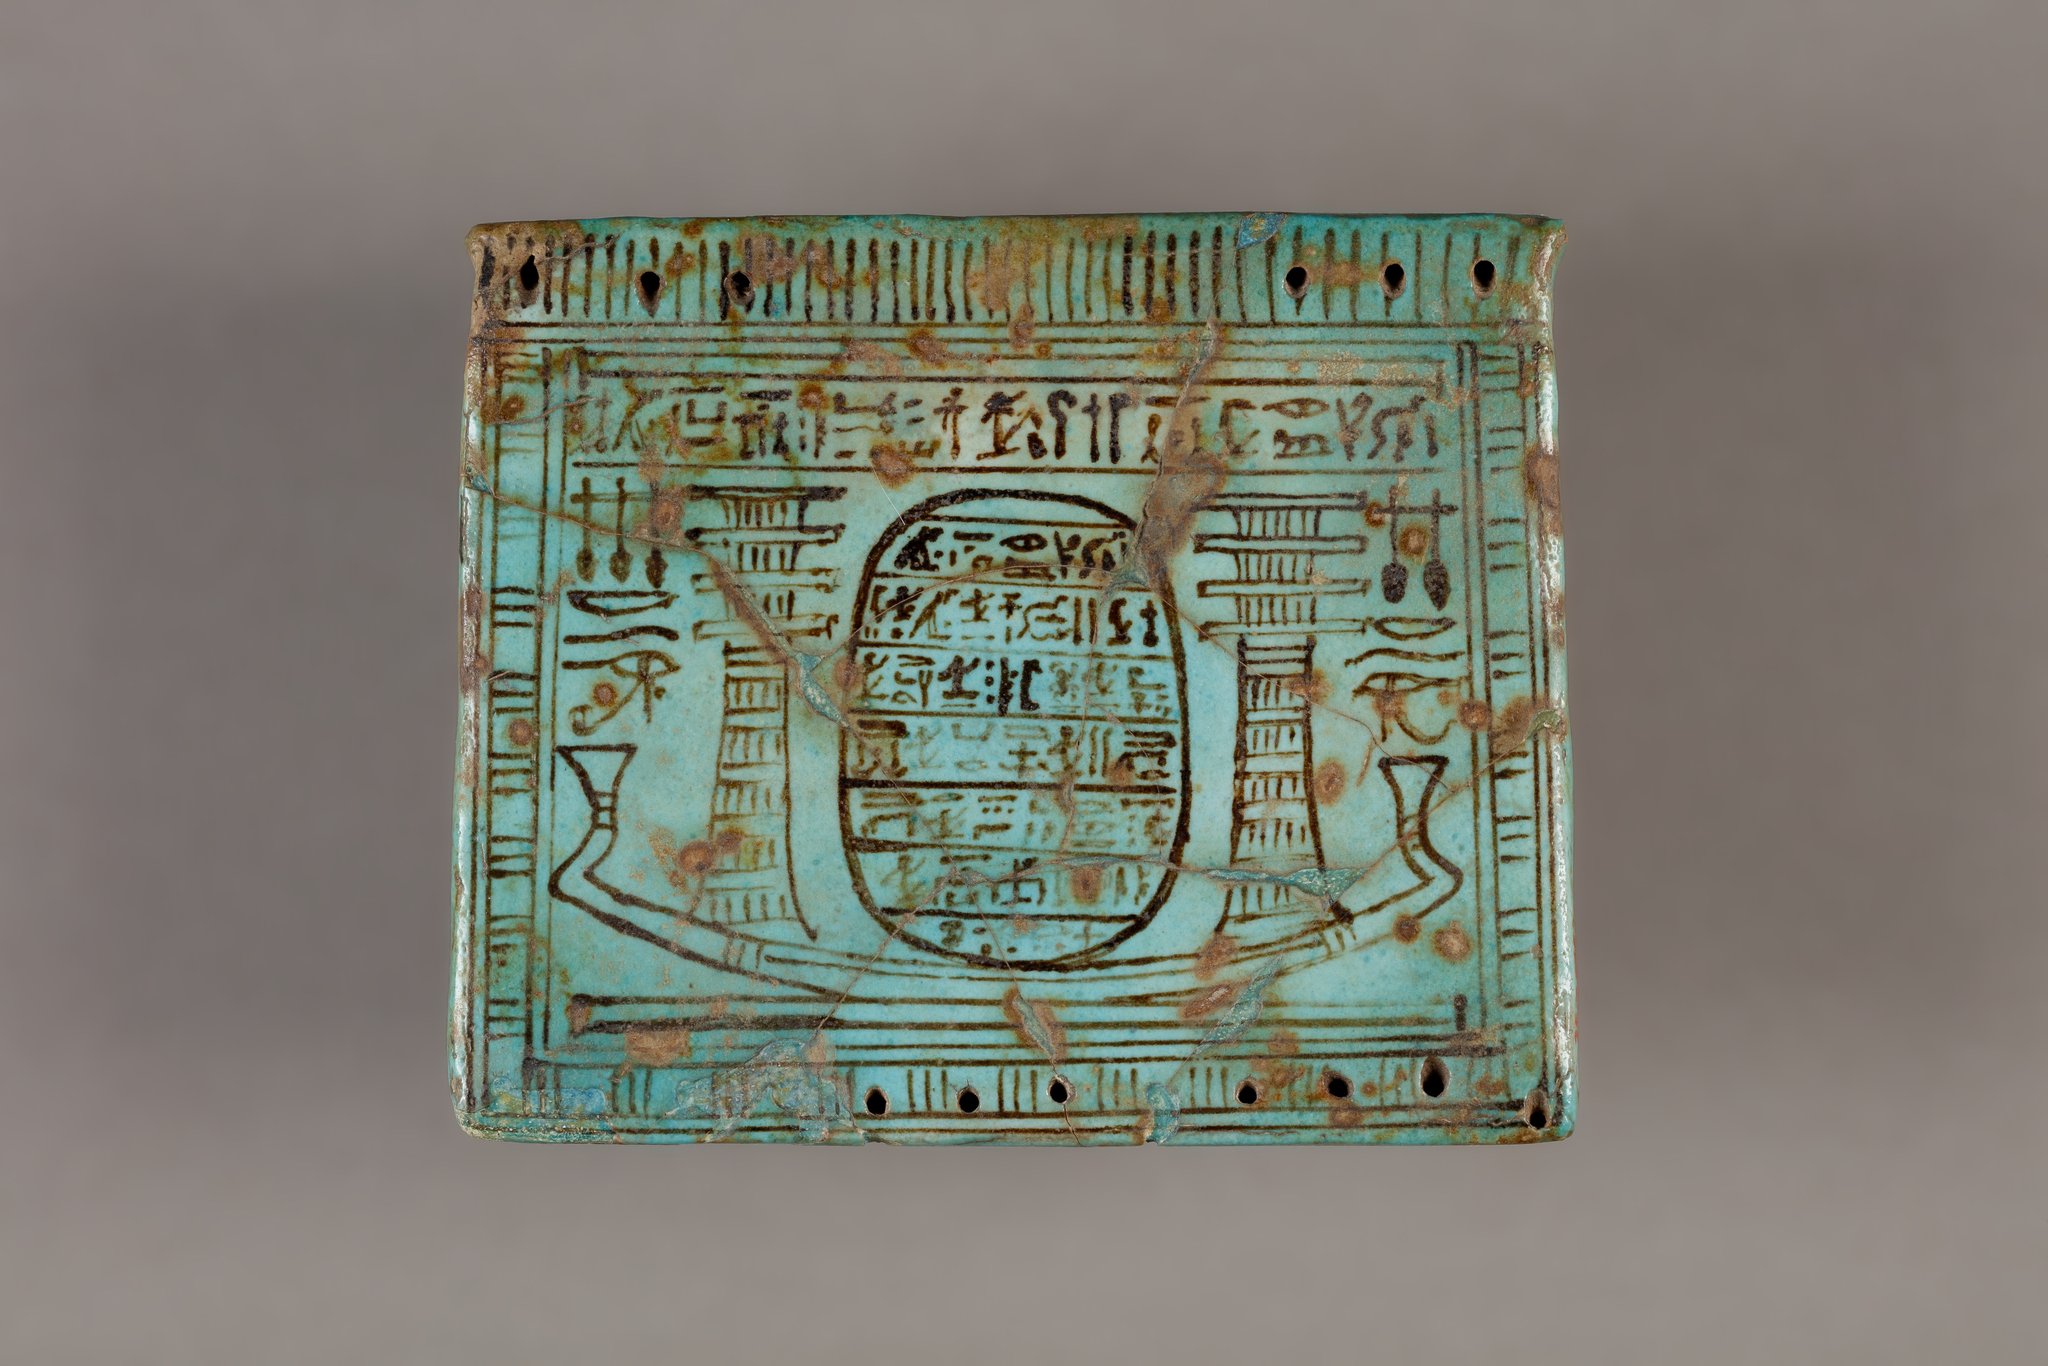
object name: pectoral, mutnefret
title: Pectoral of Mutnefret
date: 1295-1070 BCE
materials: faience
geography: egypt